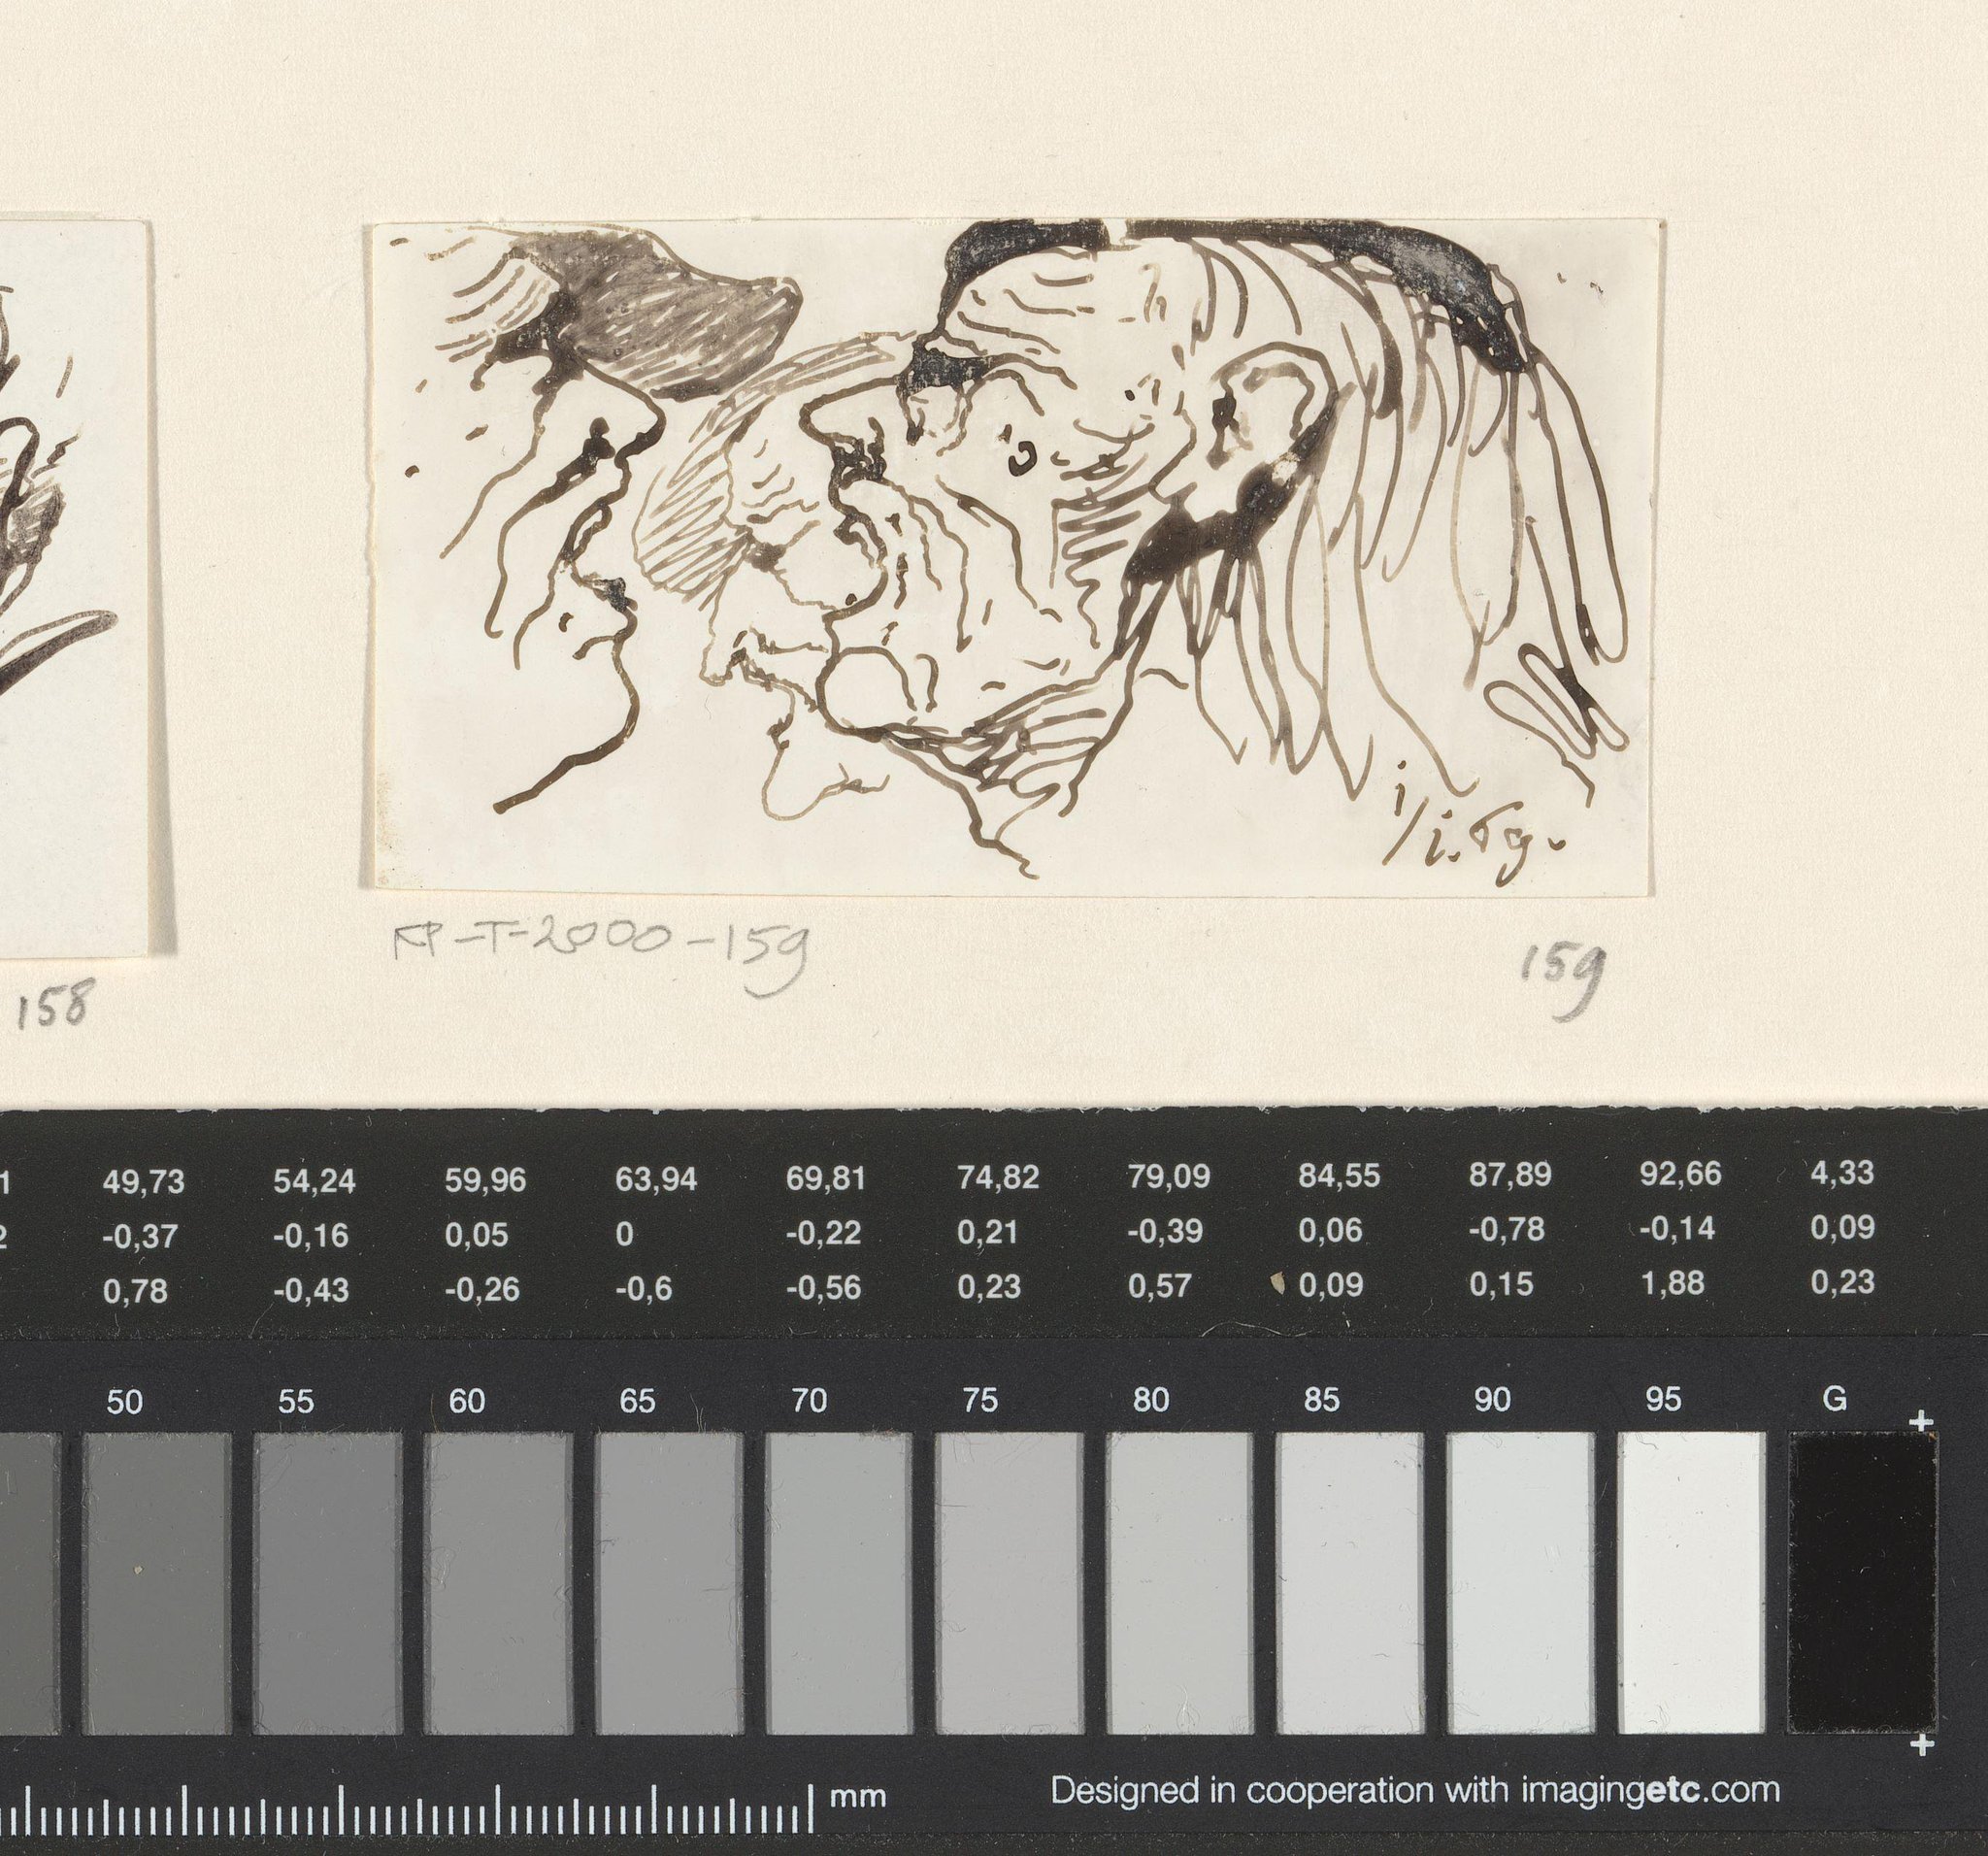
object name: visiting card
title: Drie koppen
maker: johannes tavenraat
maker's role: draughtsman, painter, print maker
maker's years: 1809-1881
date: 1869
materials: ink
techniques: pen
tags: caricatures (human types)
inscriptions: date: ‘1/1 69’, collector's mark: Lugt 2228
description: Drie karikaturale koppen, getekend op de keerzijde van het visitekaartje van: 'Erven van Dam'.